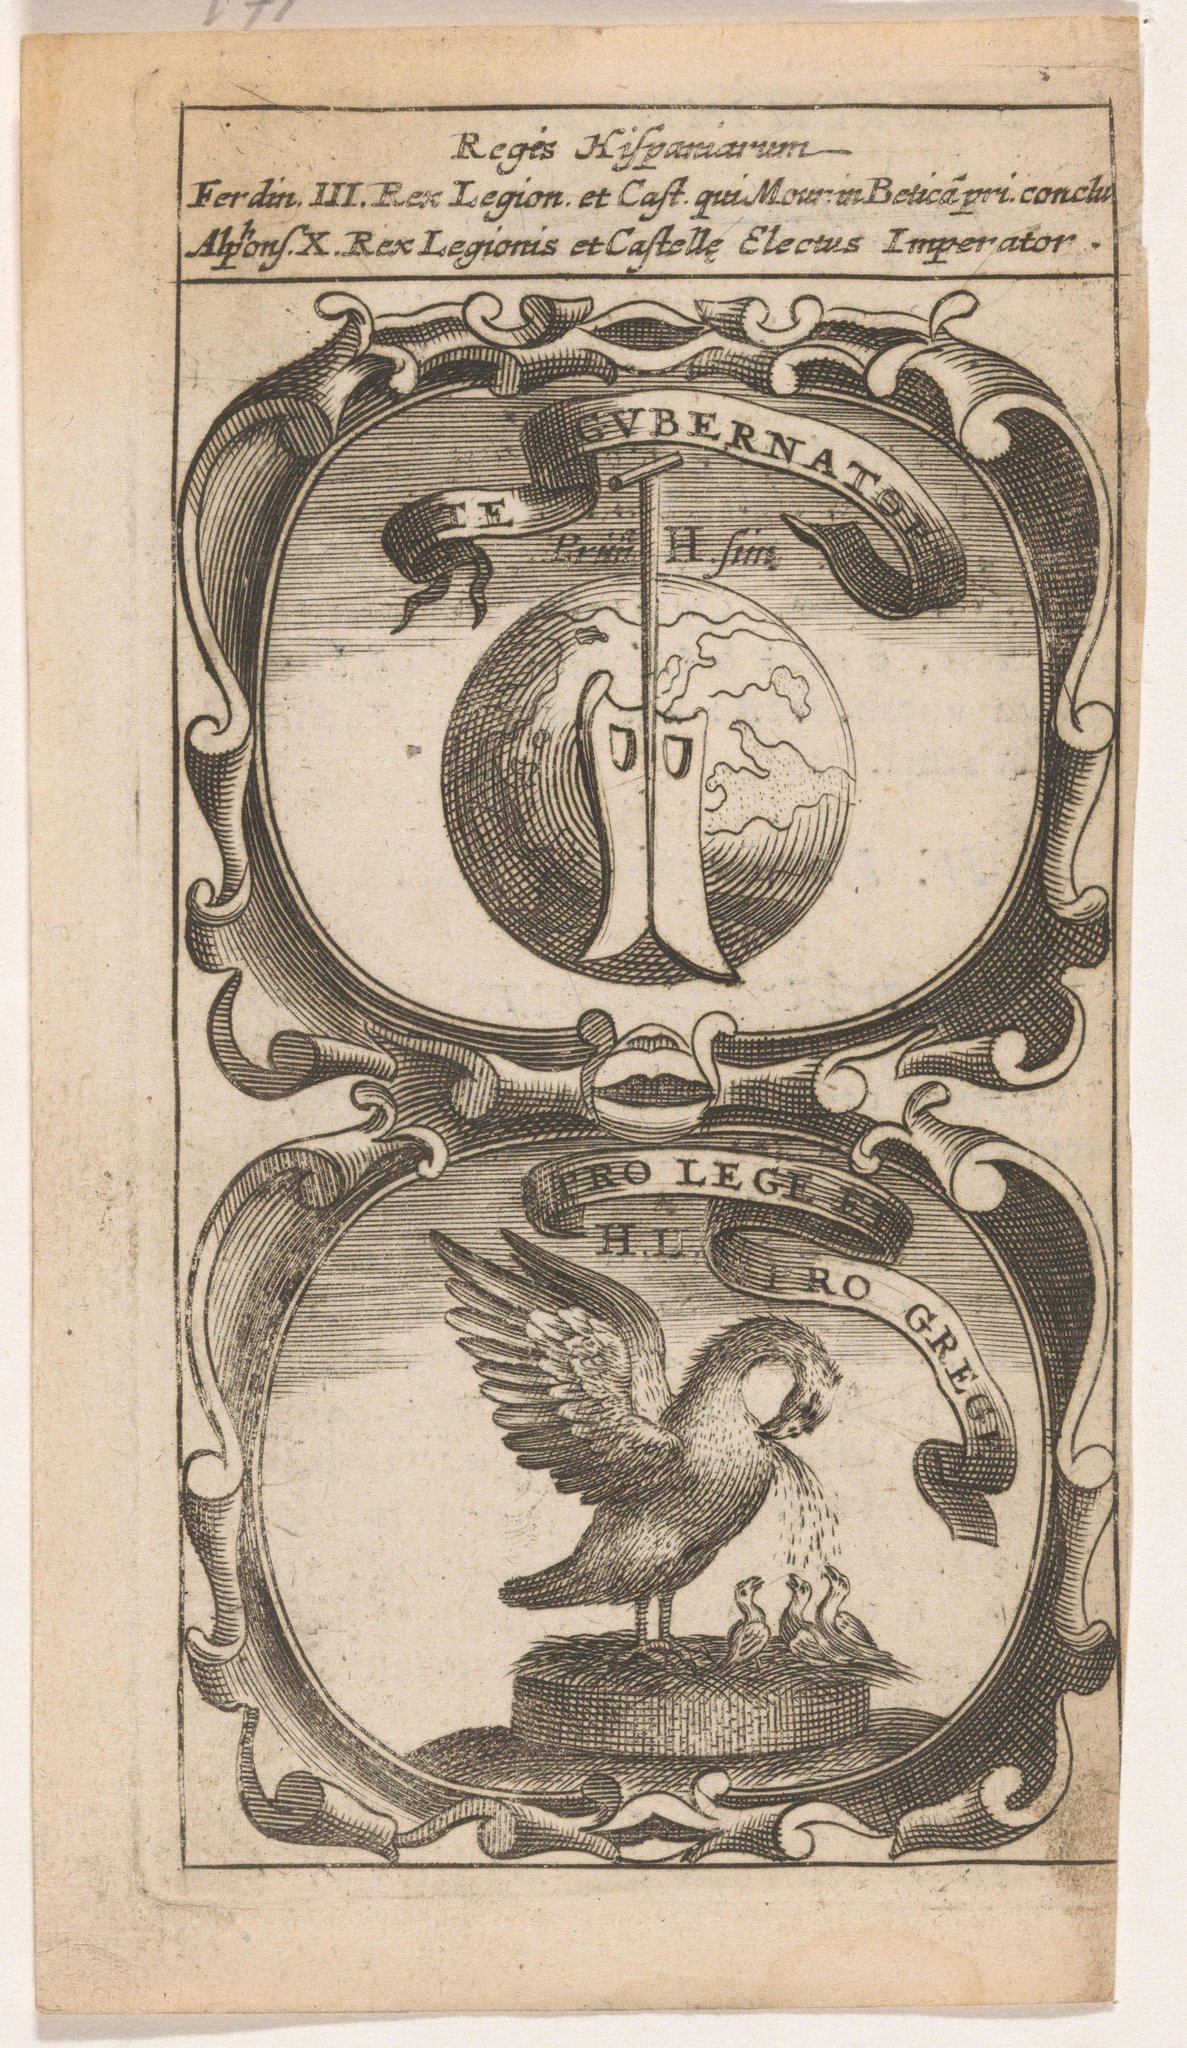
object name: print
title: Wereldbol met scheepsriem / Pelikaan voedt haar jongen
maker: Anonymous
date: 1666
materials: paper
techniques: engraving, letterpress printing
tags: sevilla, earth, world as celestial body, parts of ship's exterior, water-birds: pelican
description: Pagina uit Jacob Typotius, Symbola Divina & Humana Pontificum Imperatorum Regum. Arnhem, J.F. Hagen, 1666 of uit de titeluitgave van 1669 of 1679. Het werk van Typotius werd voor het eerst uitgegeven in 1601 met prenten van Aegidius Sadeler.